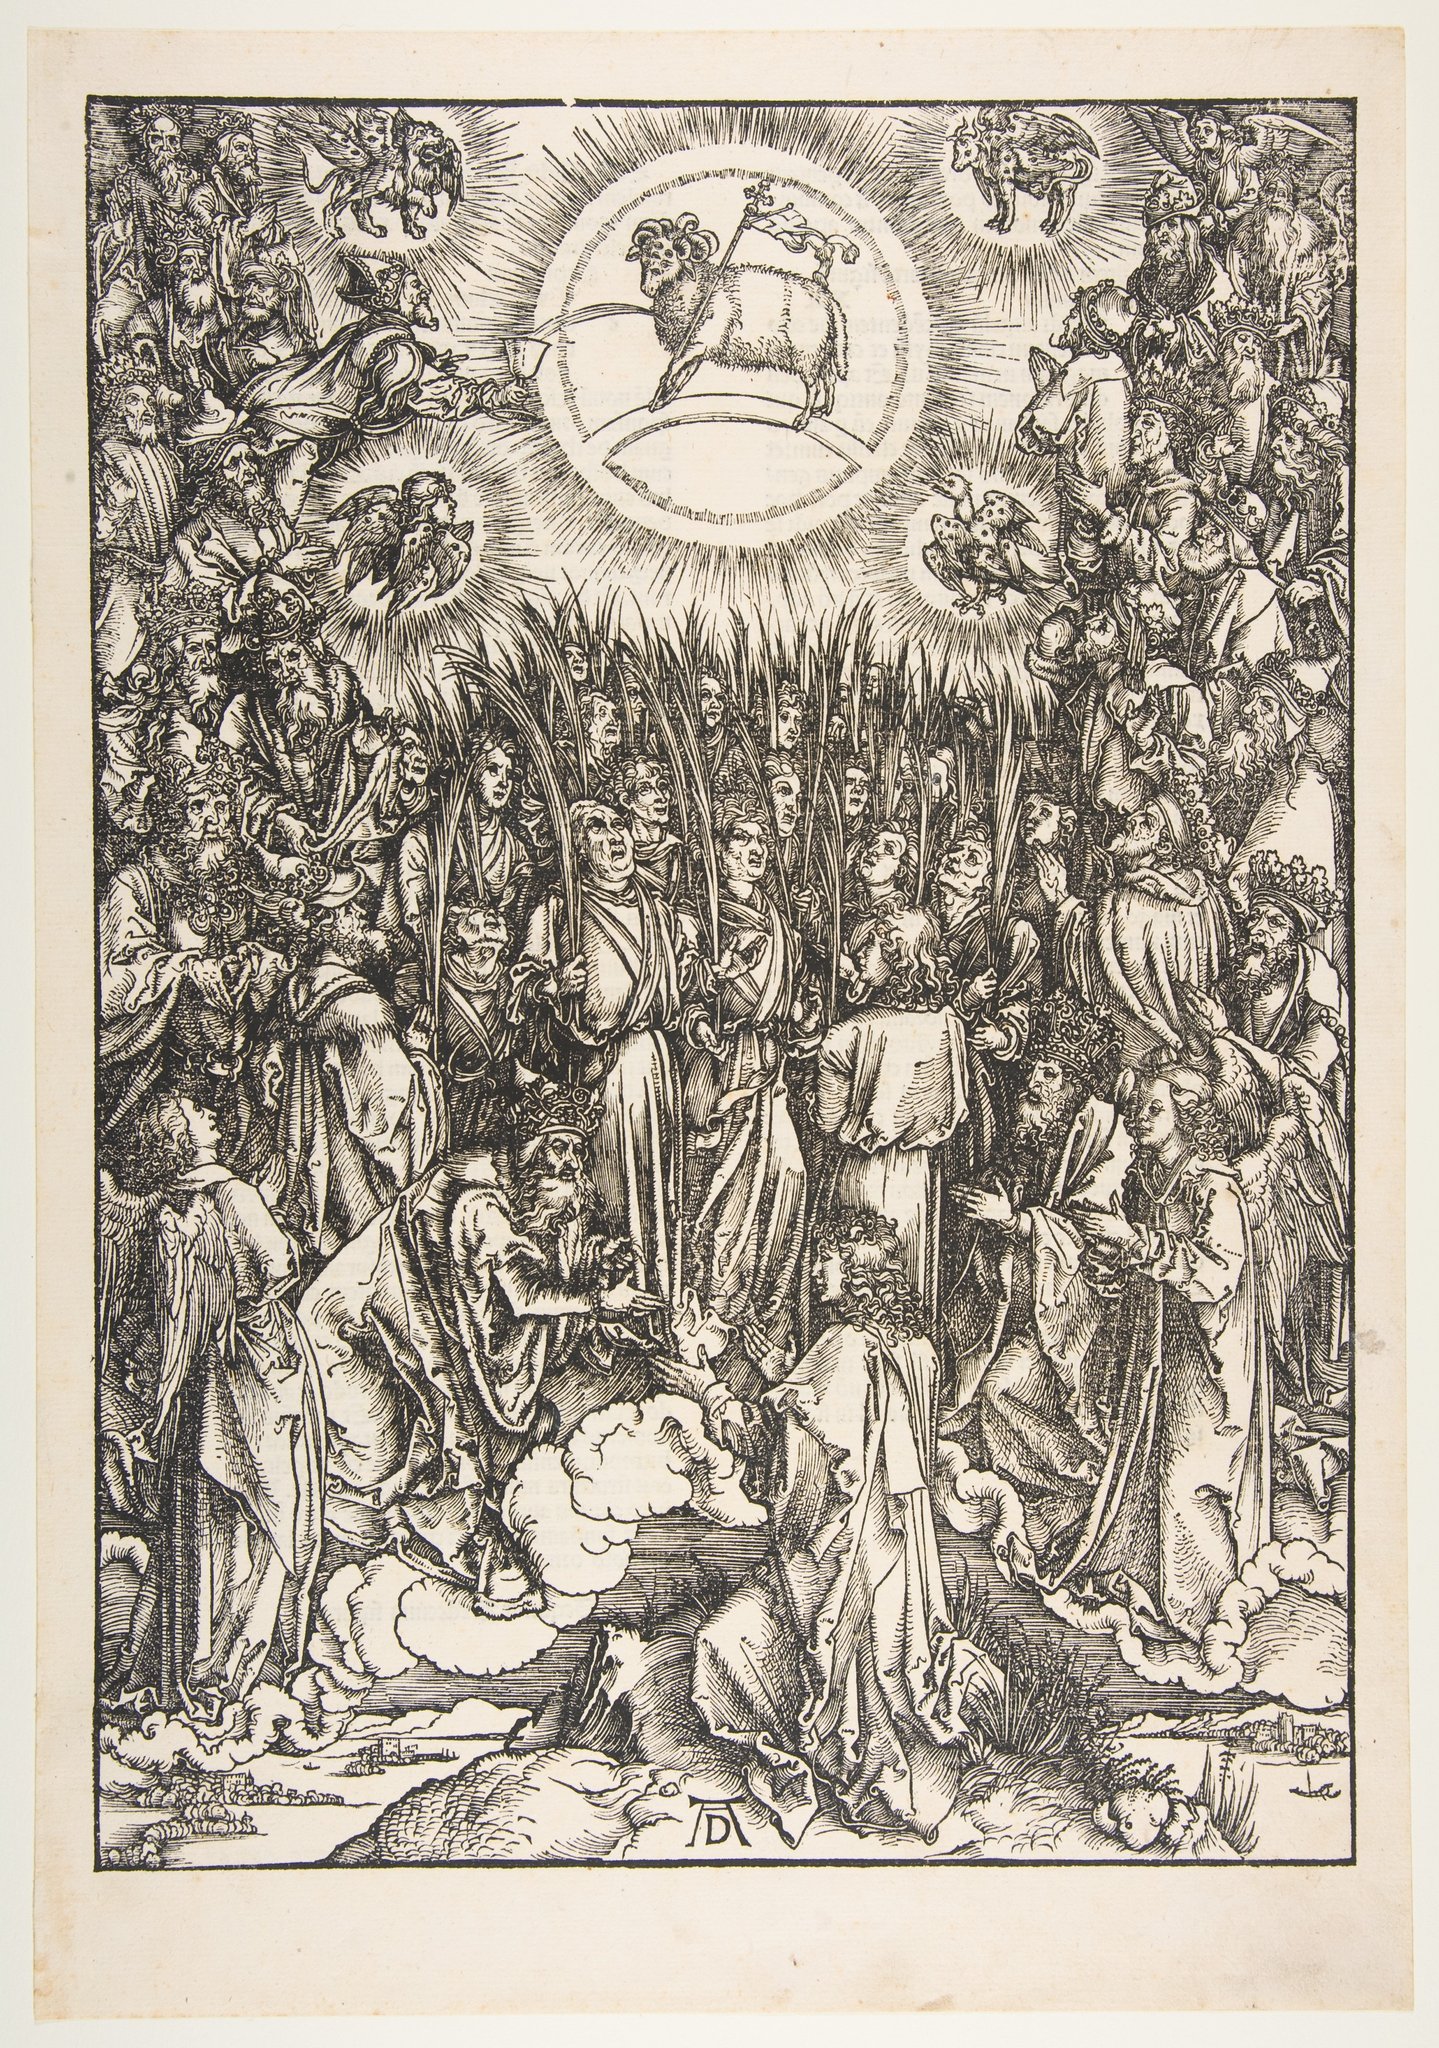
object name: print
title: The Adoration of the Lamb, from "The Apocalypse"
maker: albrecht dürer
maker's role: artist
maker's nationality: german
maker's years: 1471-1528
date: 1498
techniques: woodcut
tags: men,lambs,apocalypse